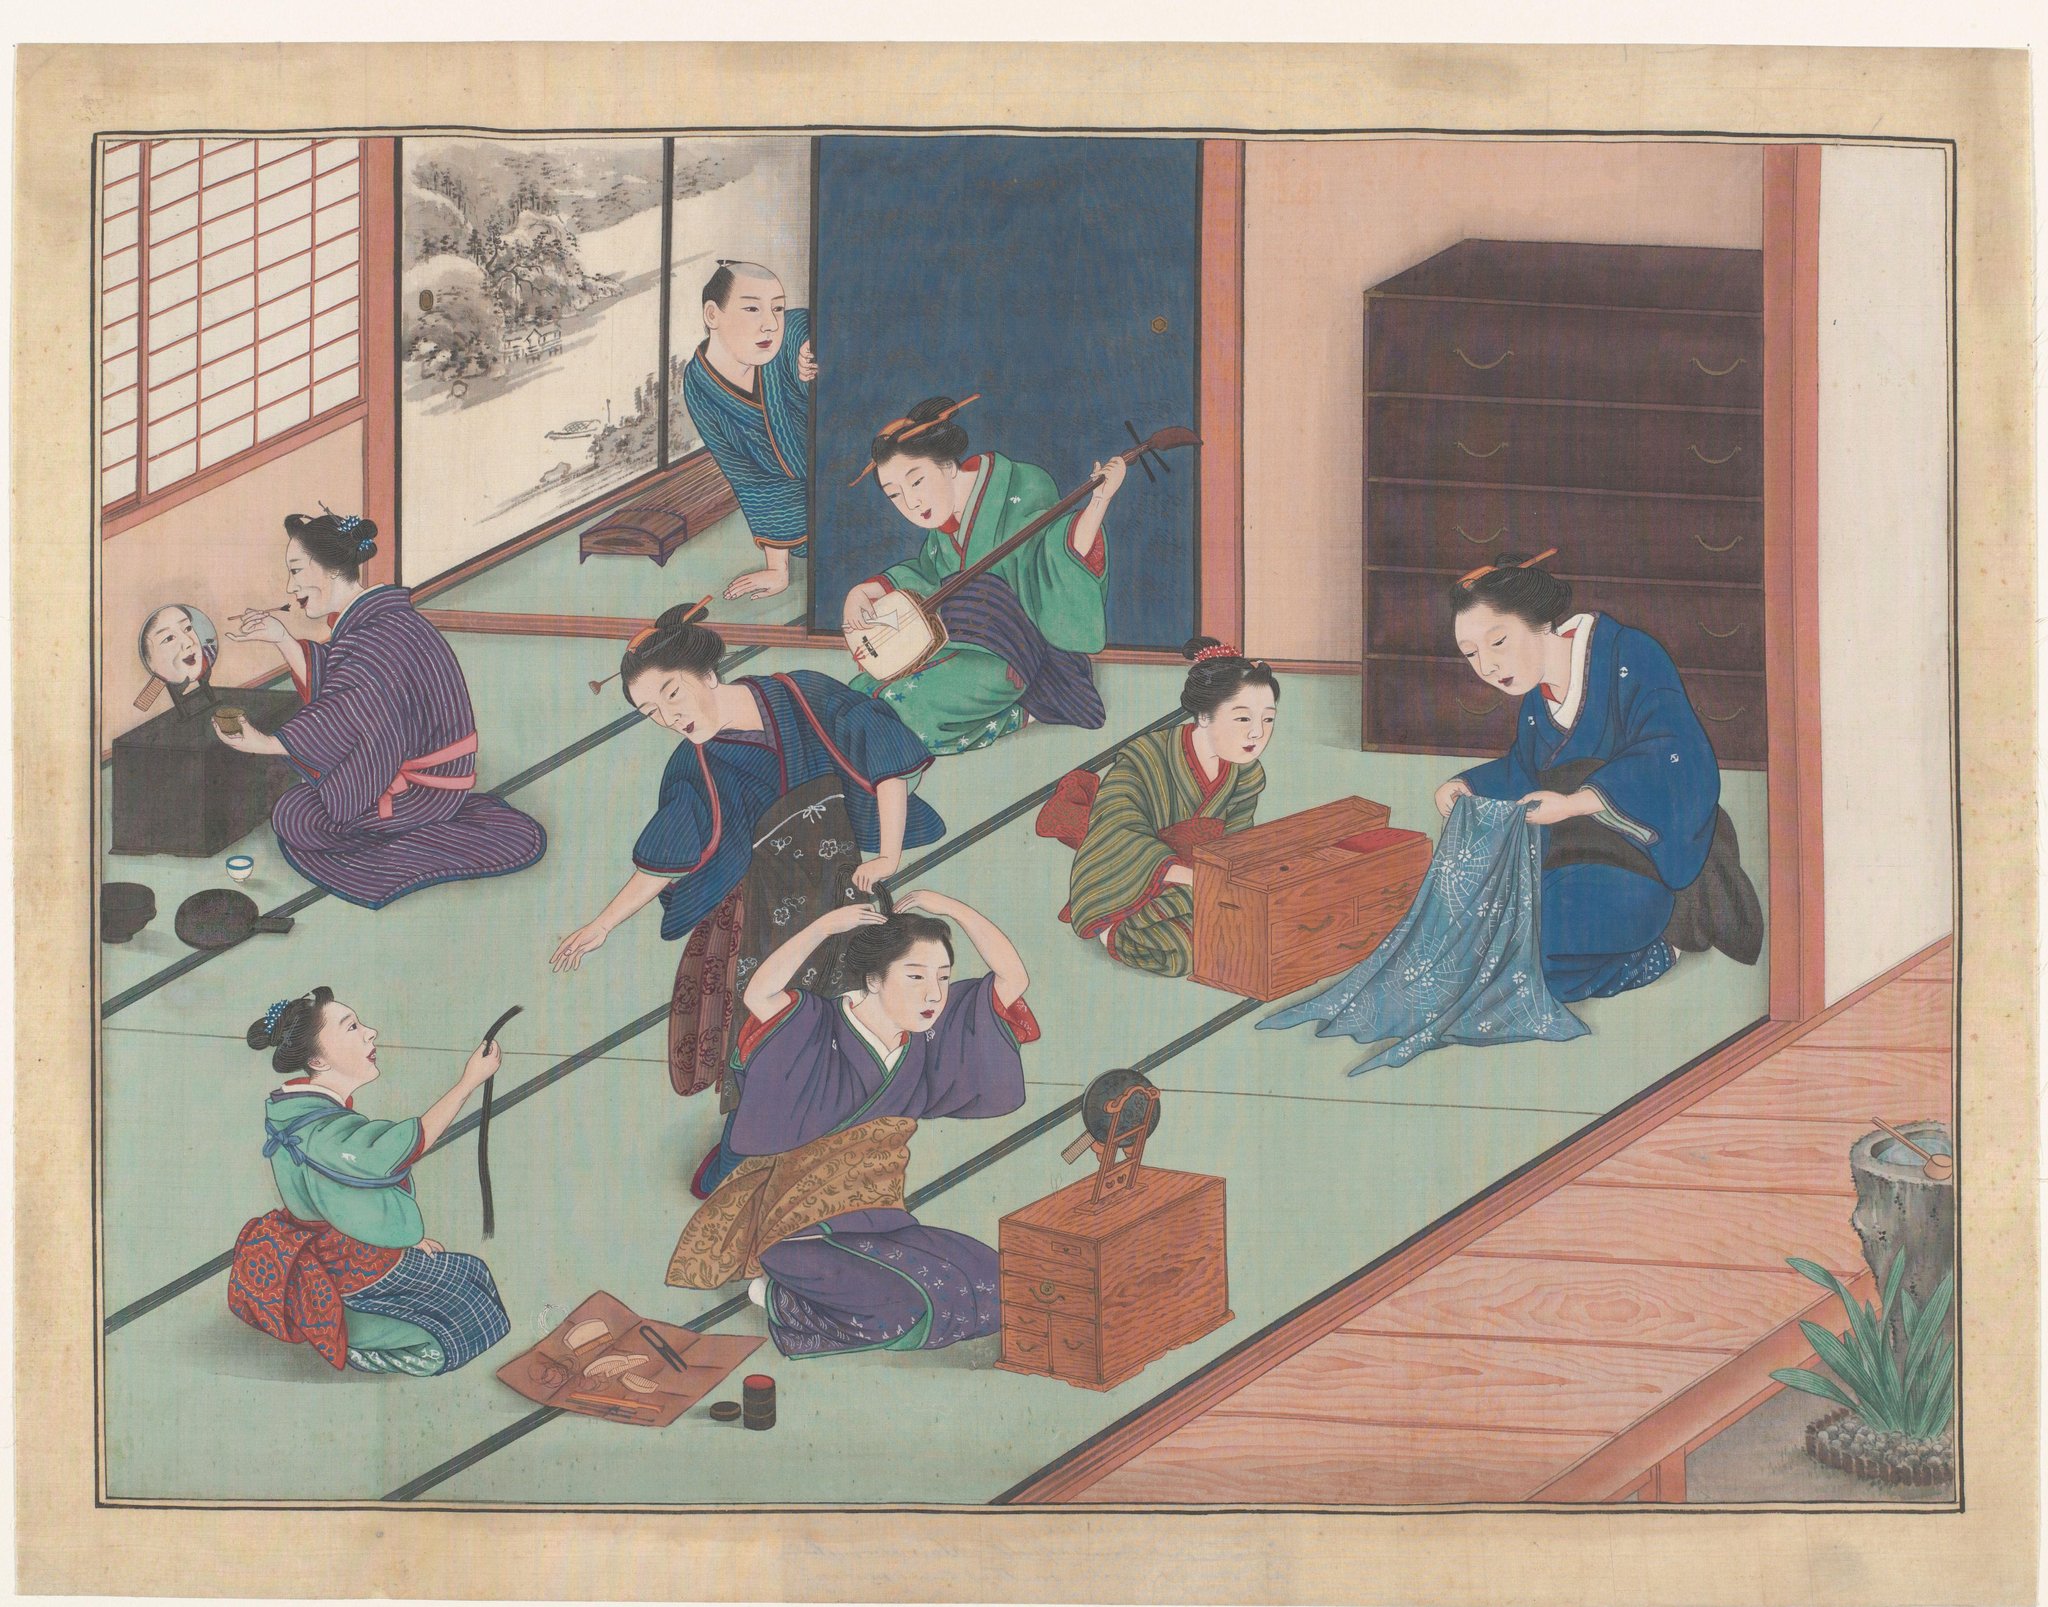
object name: drawing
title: Enige Japanse vrouwen aan het werk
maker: Anonymous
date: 1800-1900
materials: silk, watercolor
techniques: brush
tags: making toilet, one person playing string instrument (plucked), japan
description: Enige Japanse vrouwen aan de arbeid, één verstelt een kledingstuk, een tweede maakt een schoen, een derde kapt zich, een vierde schildert zich de tanden, terwijl een vijfde er bij op een snaarinstrument speelt en een man om een hoek kijkt.